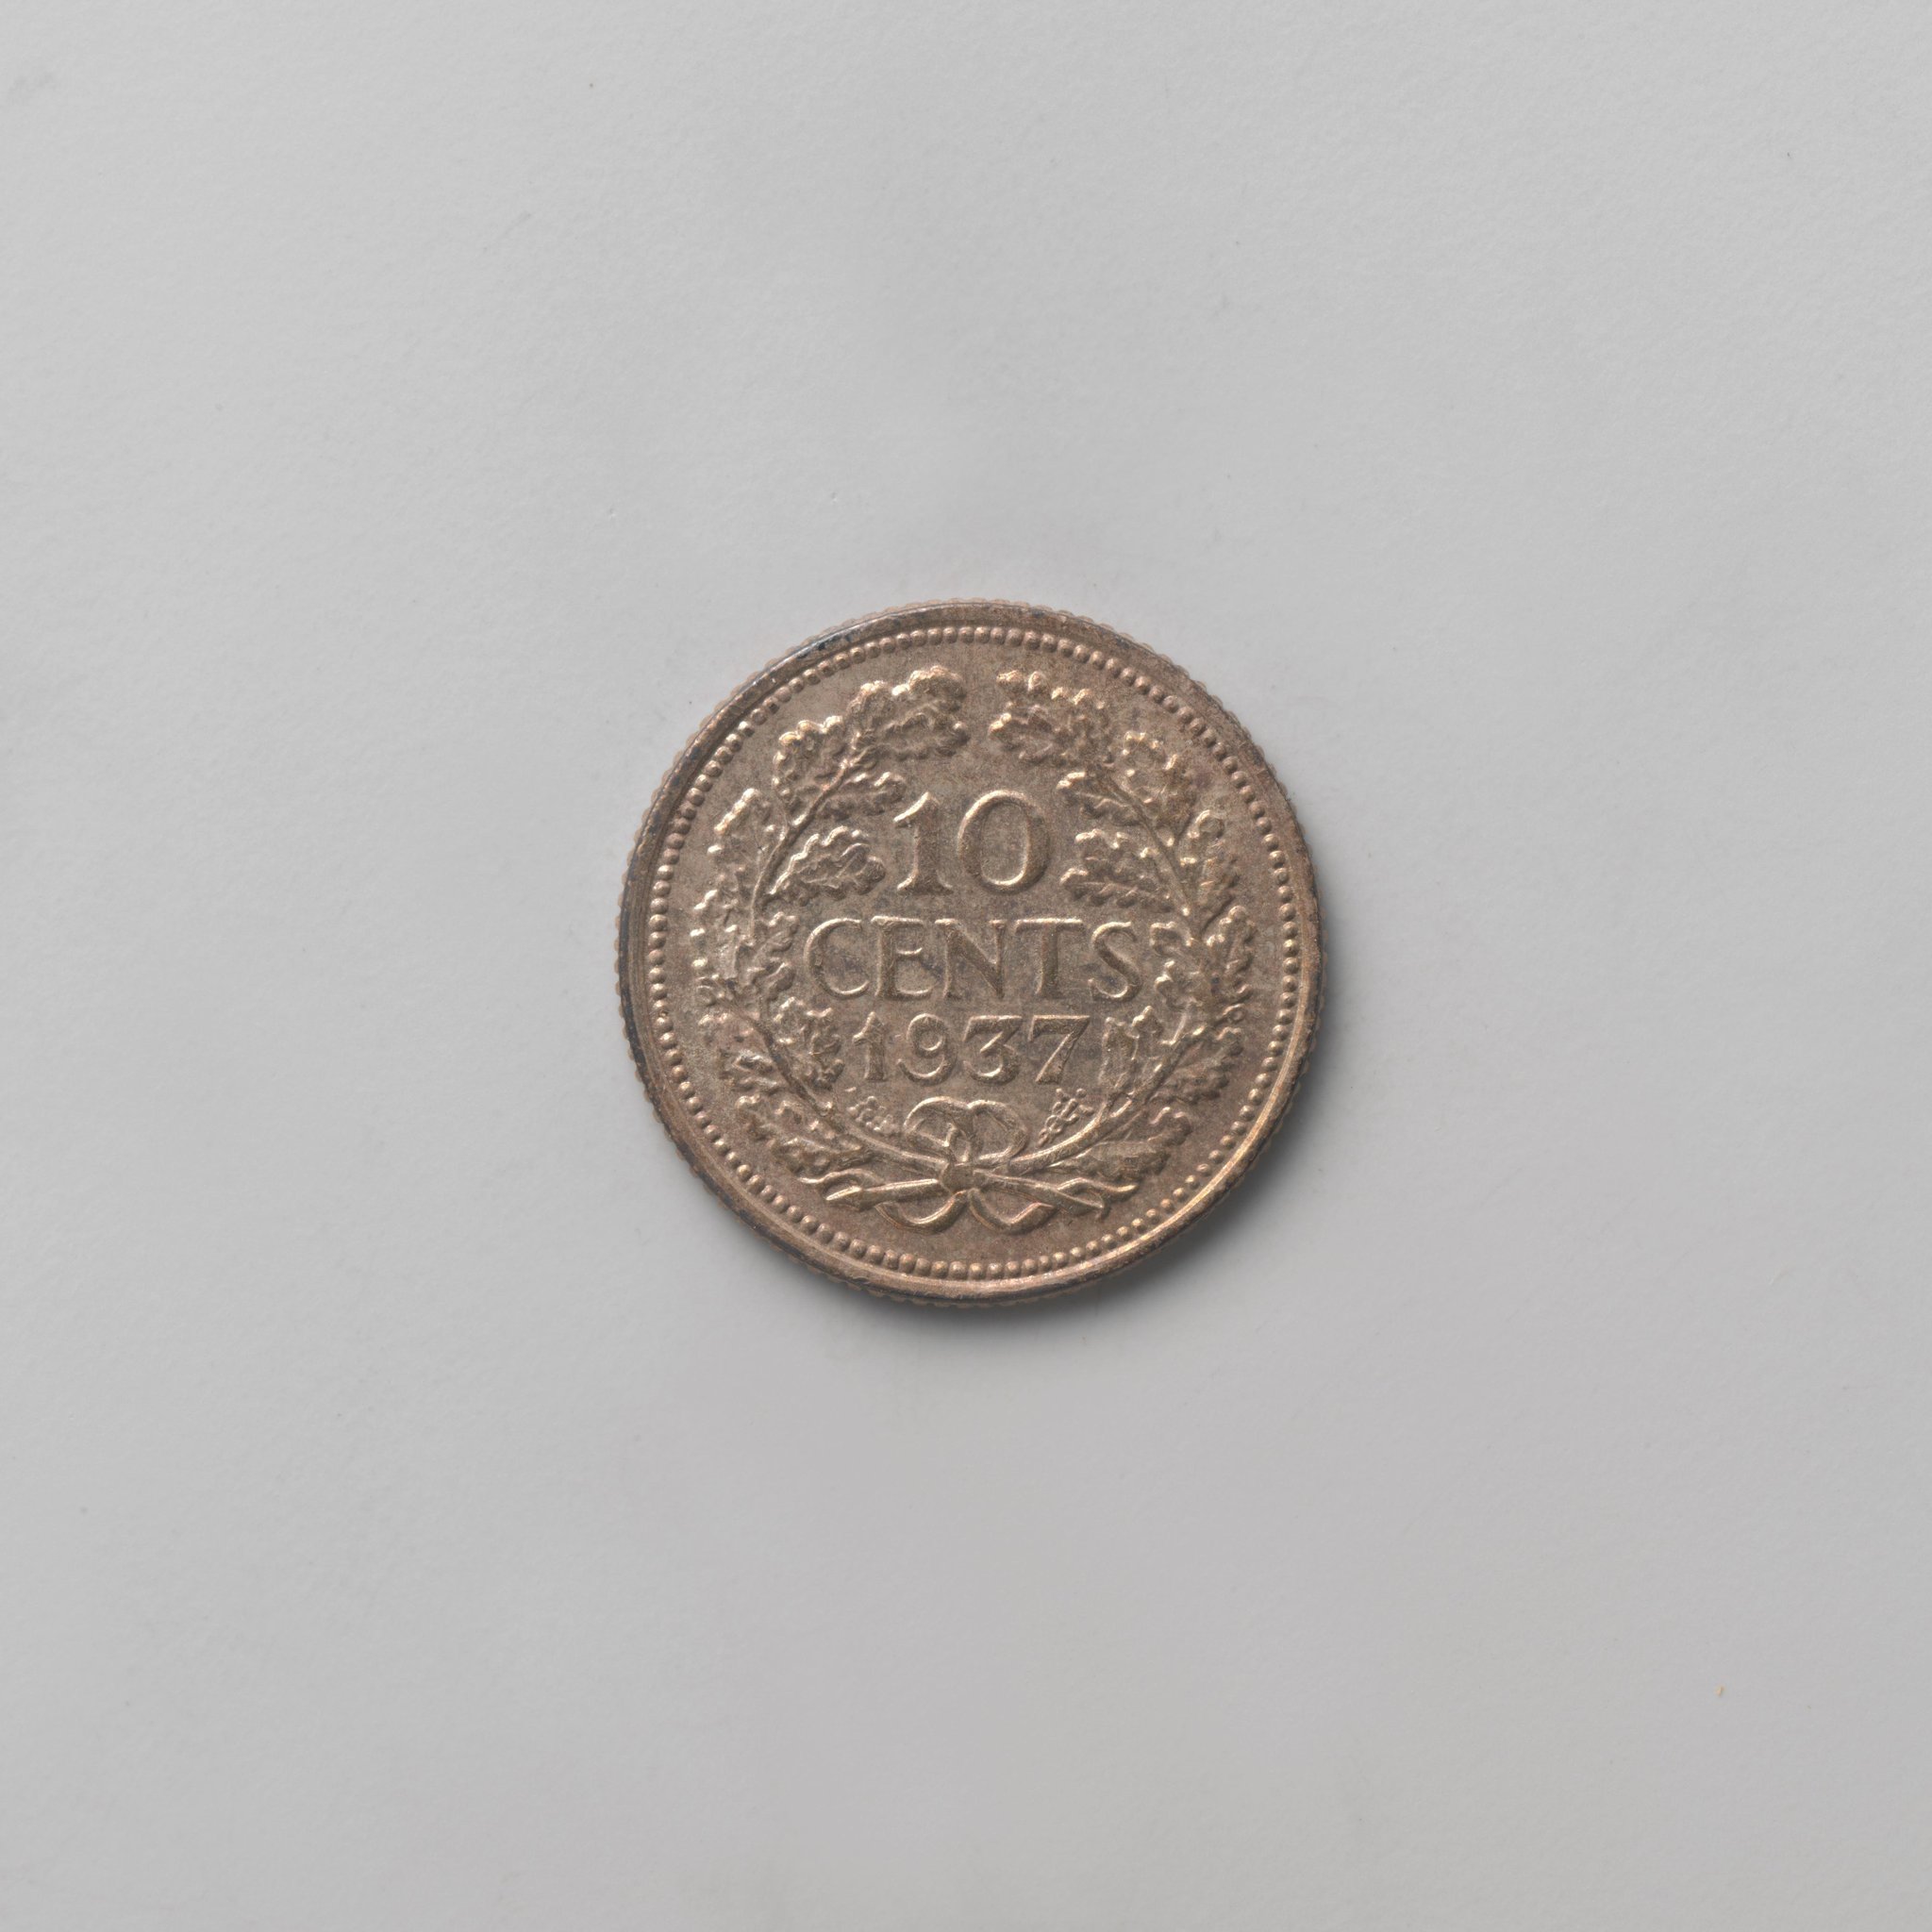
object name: coin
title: Nederlandse10 cent,1937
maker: wilhelmina of the netherlands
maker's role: print maker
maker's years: 1880-1962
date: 1937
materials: silver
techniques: striking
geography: utrecht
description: Zilveren munt. Voorzijde: hoofd naar links. Keerzijde: binnen twee samengebonden eiketakken waarde-aanduiding 10 cents en jaartal. Kartelrand.